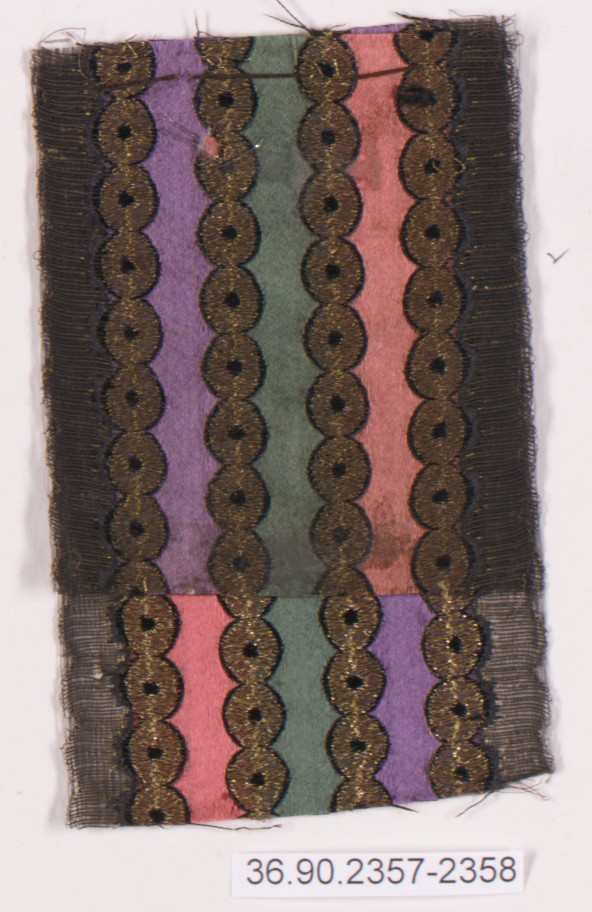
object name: ribbon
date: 1801-1900